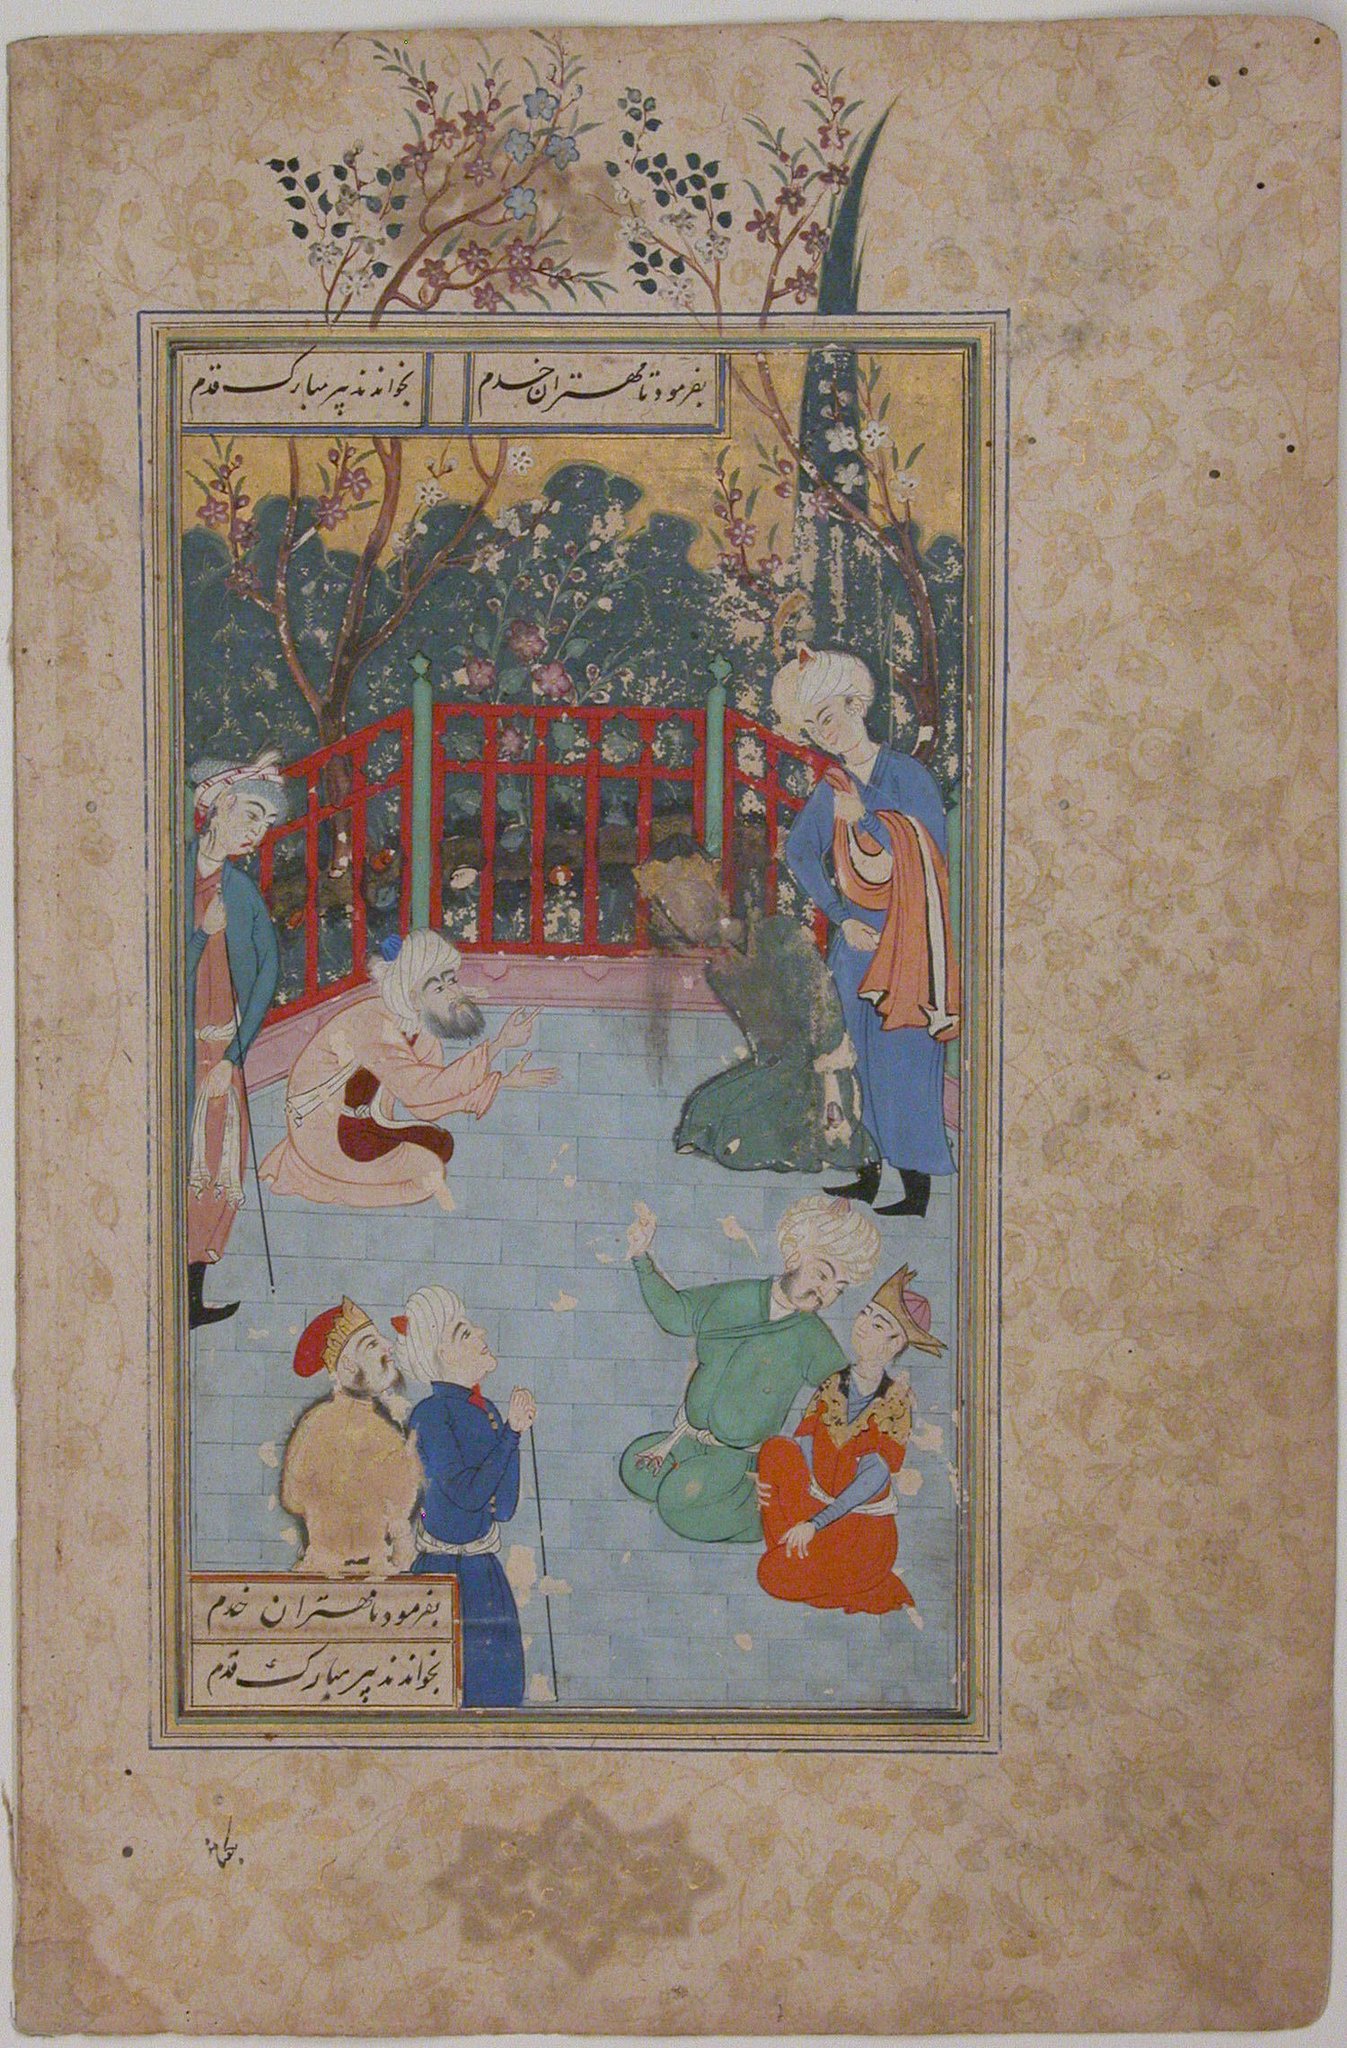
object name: folio from an illustrated manuscript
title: "A Religious Devotee Summoned to Pray for the King's Recovery", Folio from a Bustan (Orchard) of Sa'di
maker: sa'di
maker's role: author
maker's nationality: iranian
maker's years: 1213-1291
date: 1601-1700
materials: gold, ink, paper, watercolor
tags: men,women,praying